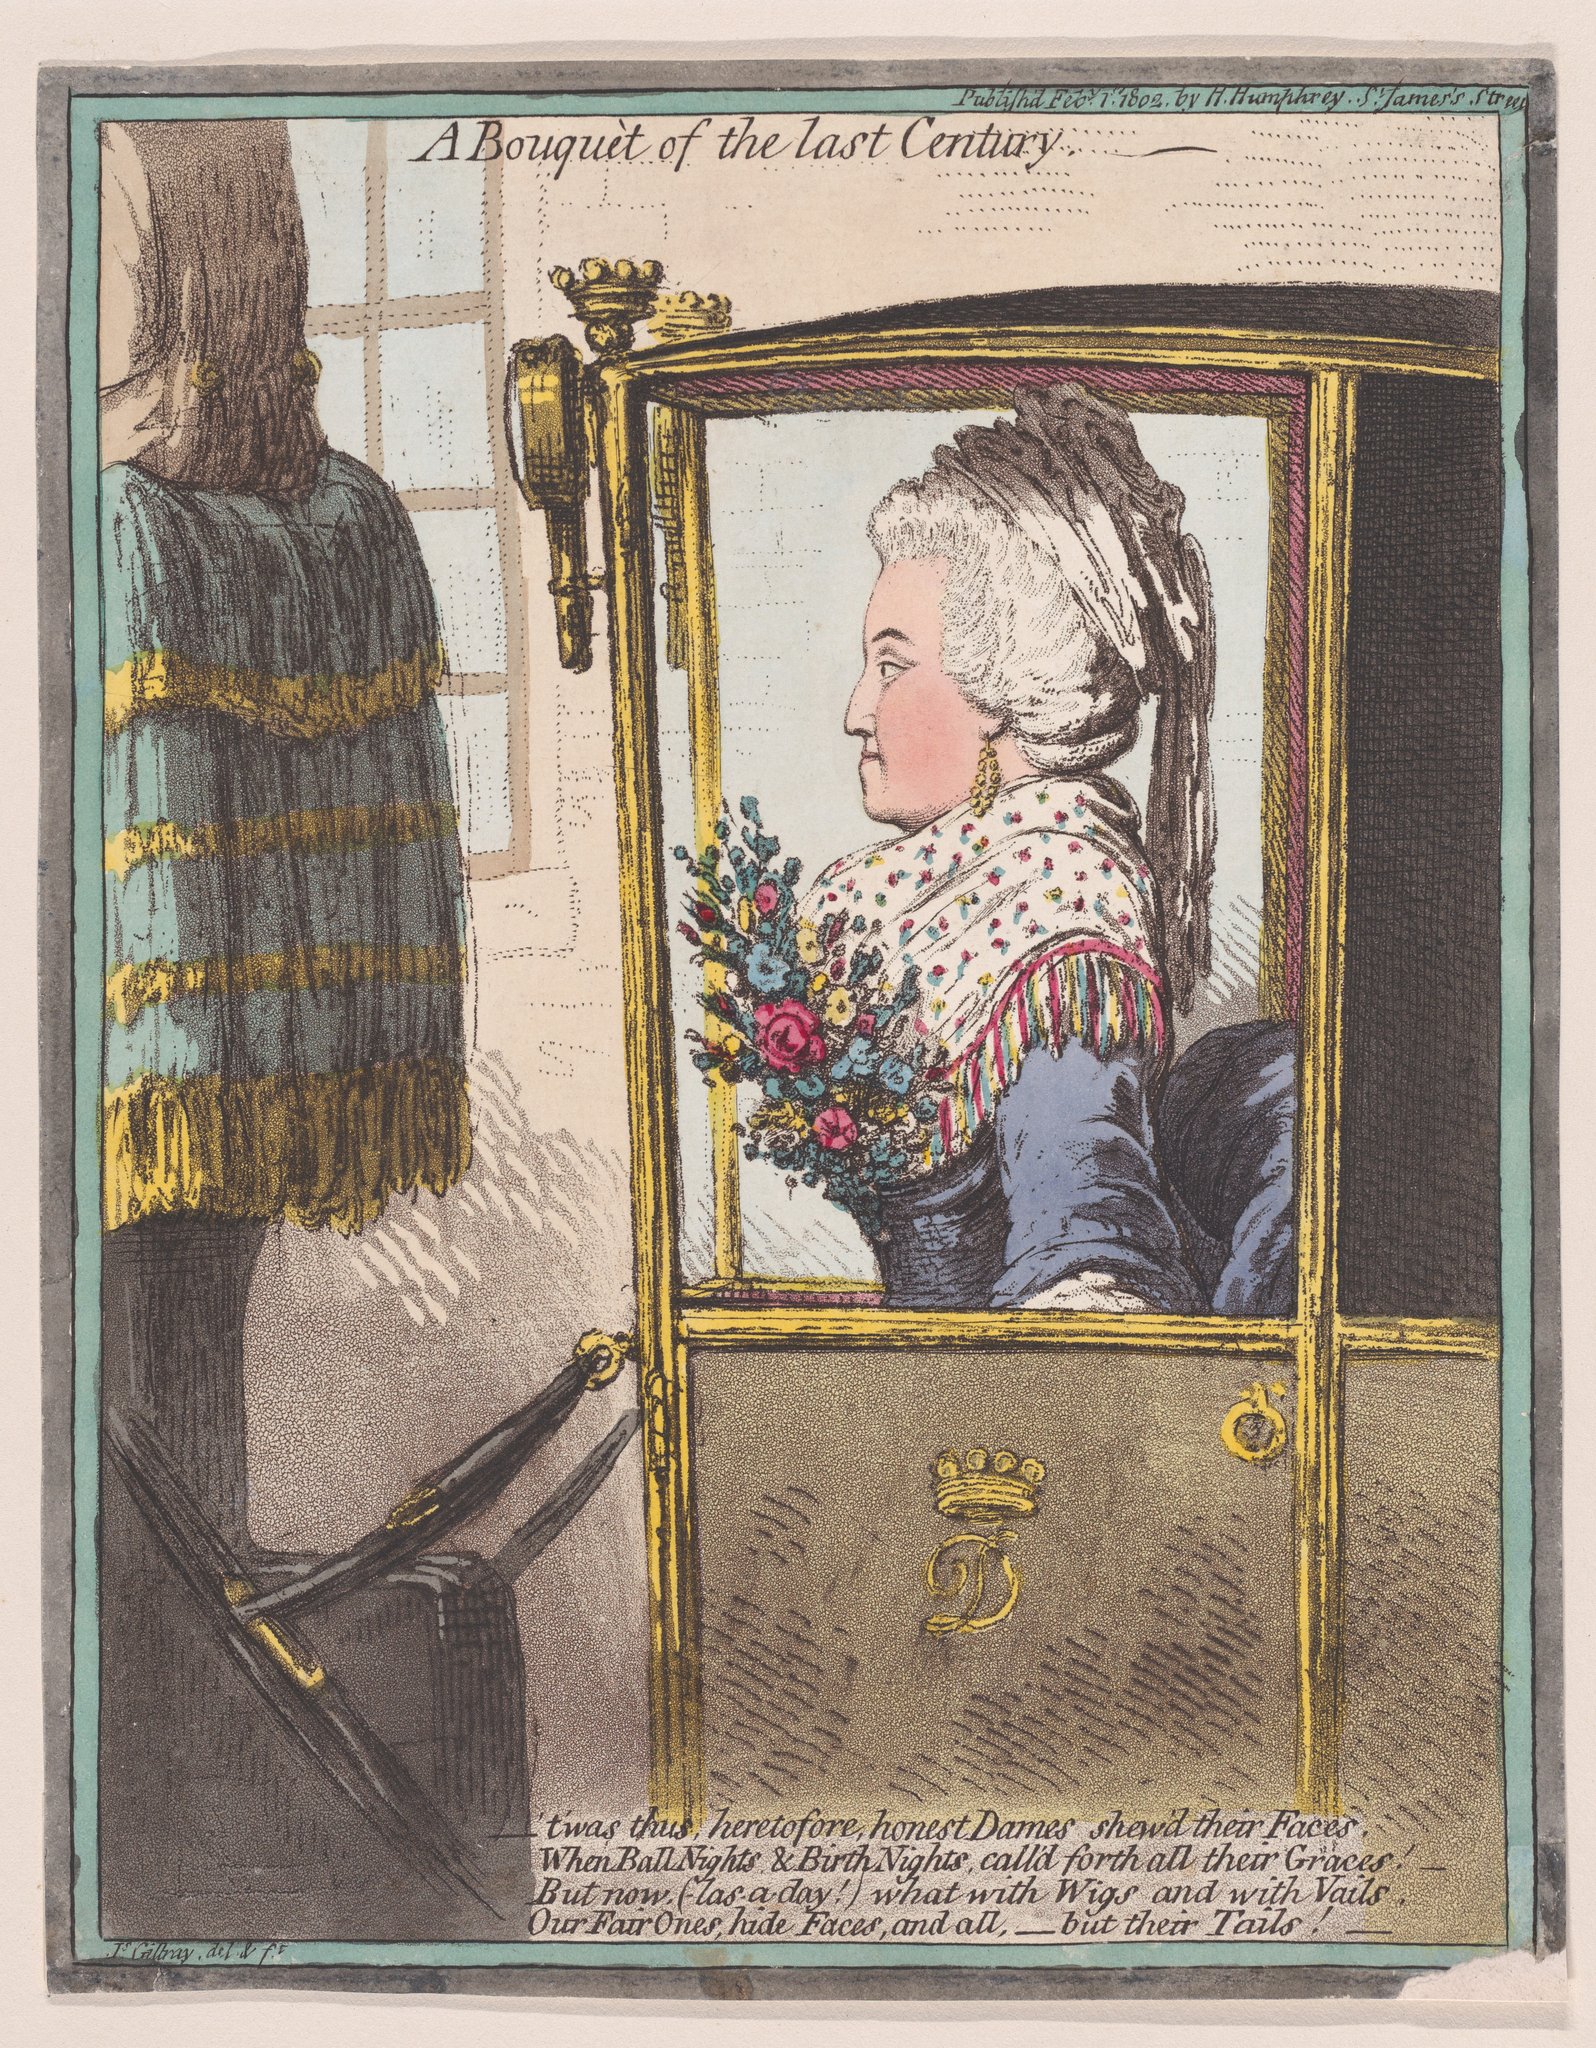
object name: print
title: A Bouquet of the Last Century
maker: james gillray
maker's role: artist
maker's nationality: british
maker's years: 1756-1815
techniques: etching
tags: women,carriages,caricature